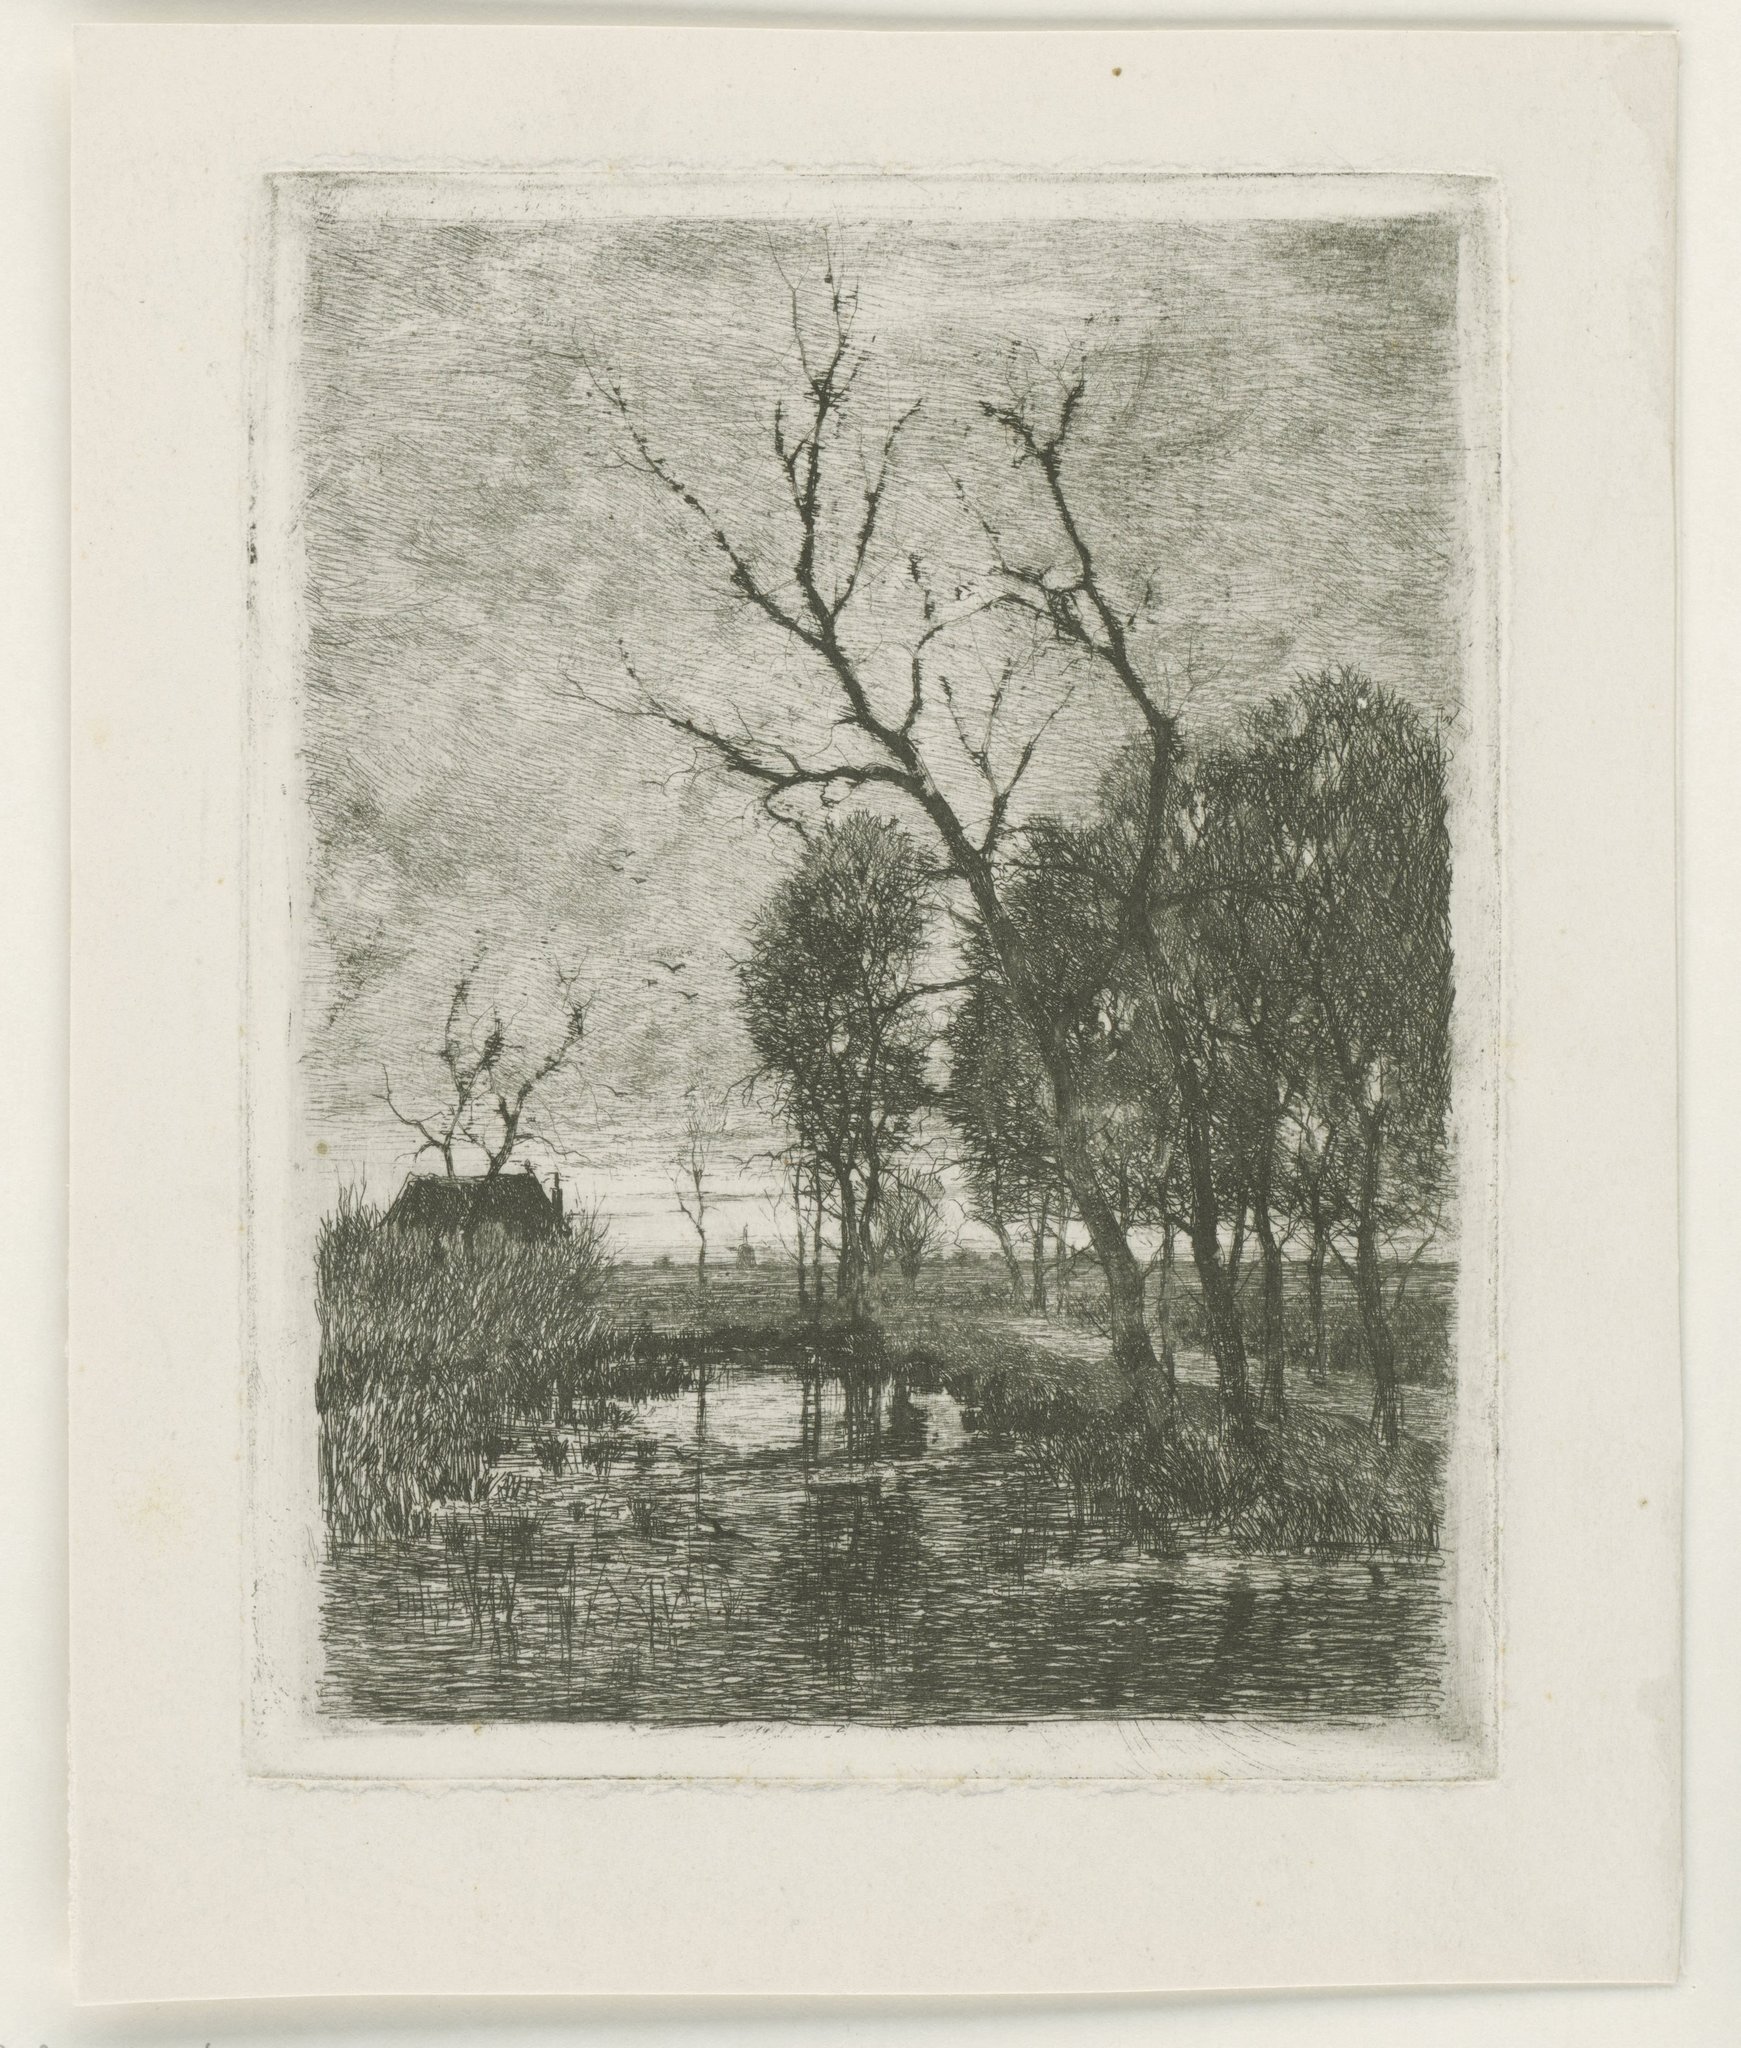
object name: print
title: Schemering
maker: fredericus jacobus van rossum du chattel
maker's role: draughtsman, painter, print maker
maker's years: 1856-1917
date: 1873-1892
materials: paper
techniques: etching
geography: netherlands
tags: landscapes with waters, waterscapes, seascapes (in the temperate zone)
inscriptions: collector's mark: Monogram van Paulus van den Velden, collector's mark: Lugt 2228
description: Waterlandschap met dijk en bomen in de schemering.